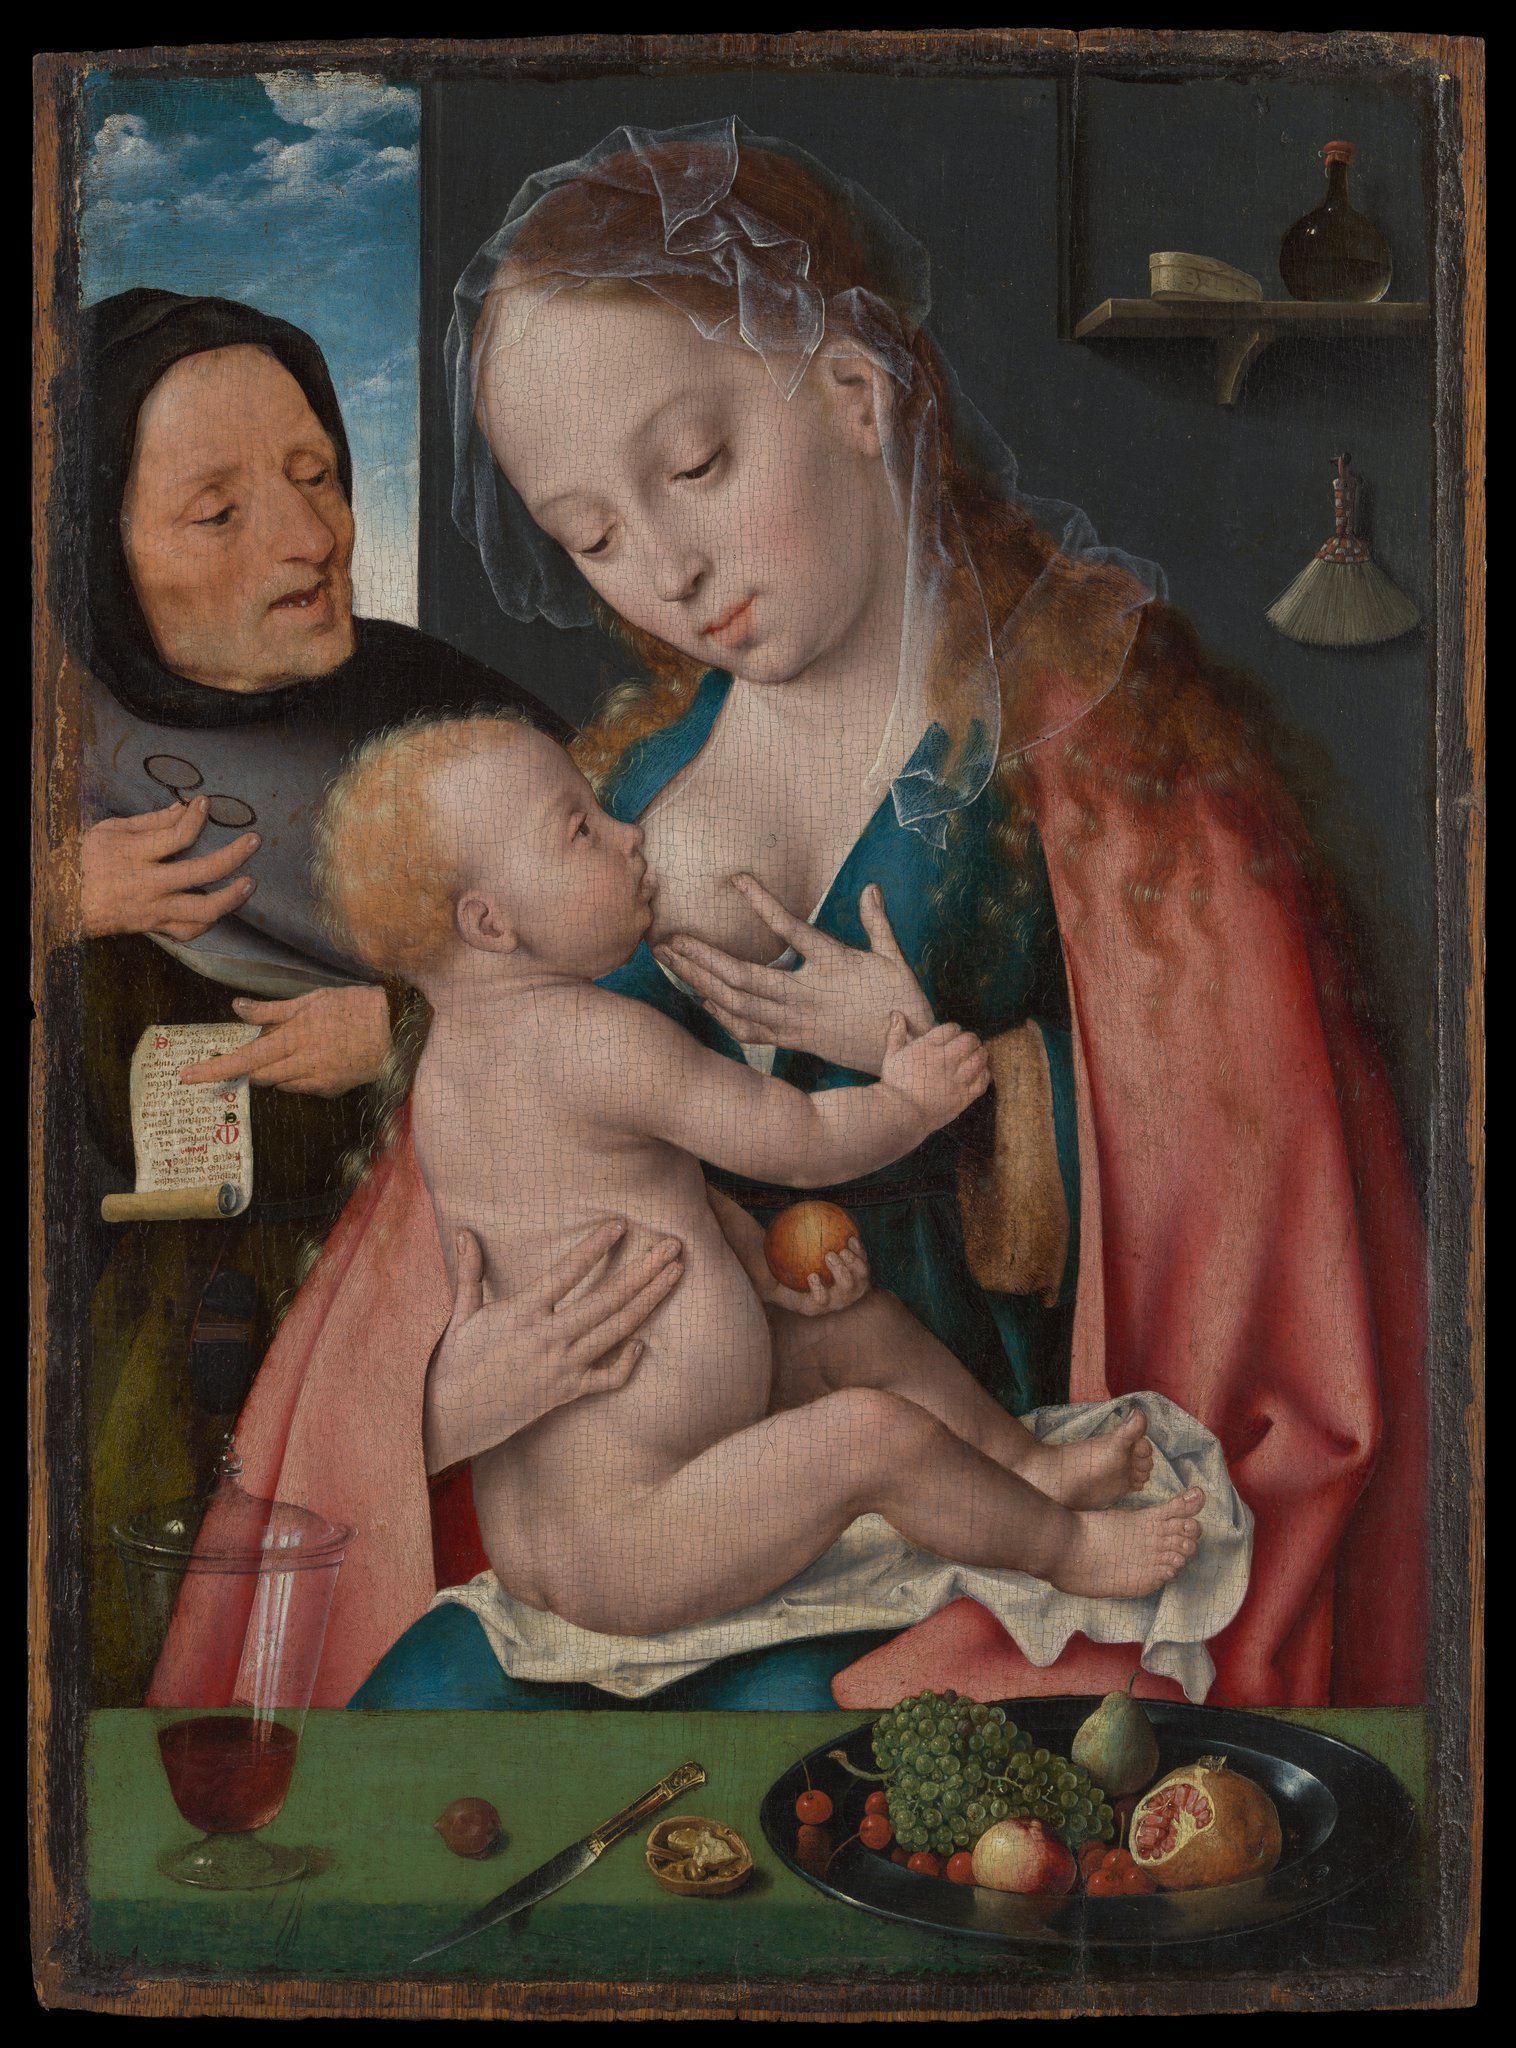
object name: painting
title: The Holy Family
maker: joos van cleve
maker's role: artist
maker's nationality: netherlandish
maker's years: 1485-1541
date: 1512-1513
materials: oil, wood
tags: fruit,grapes,women,holy family,virgin mary,jesus,nursing